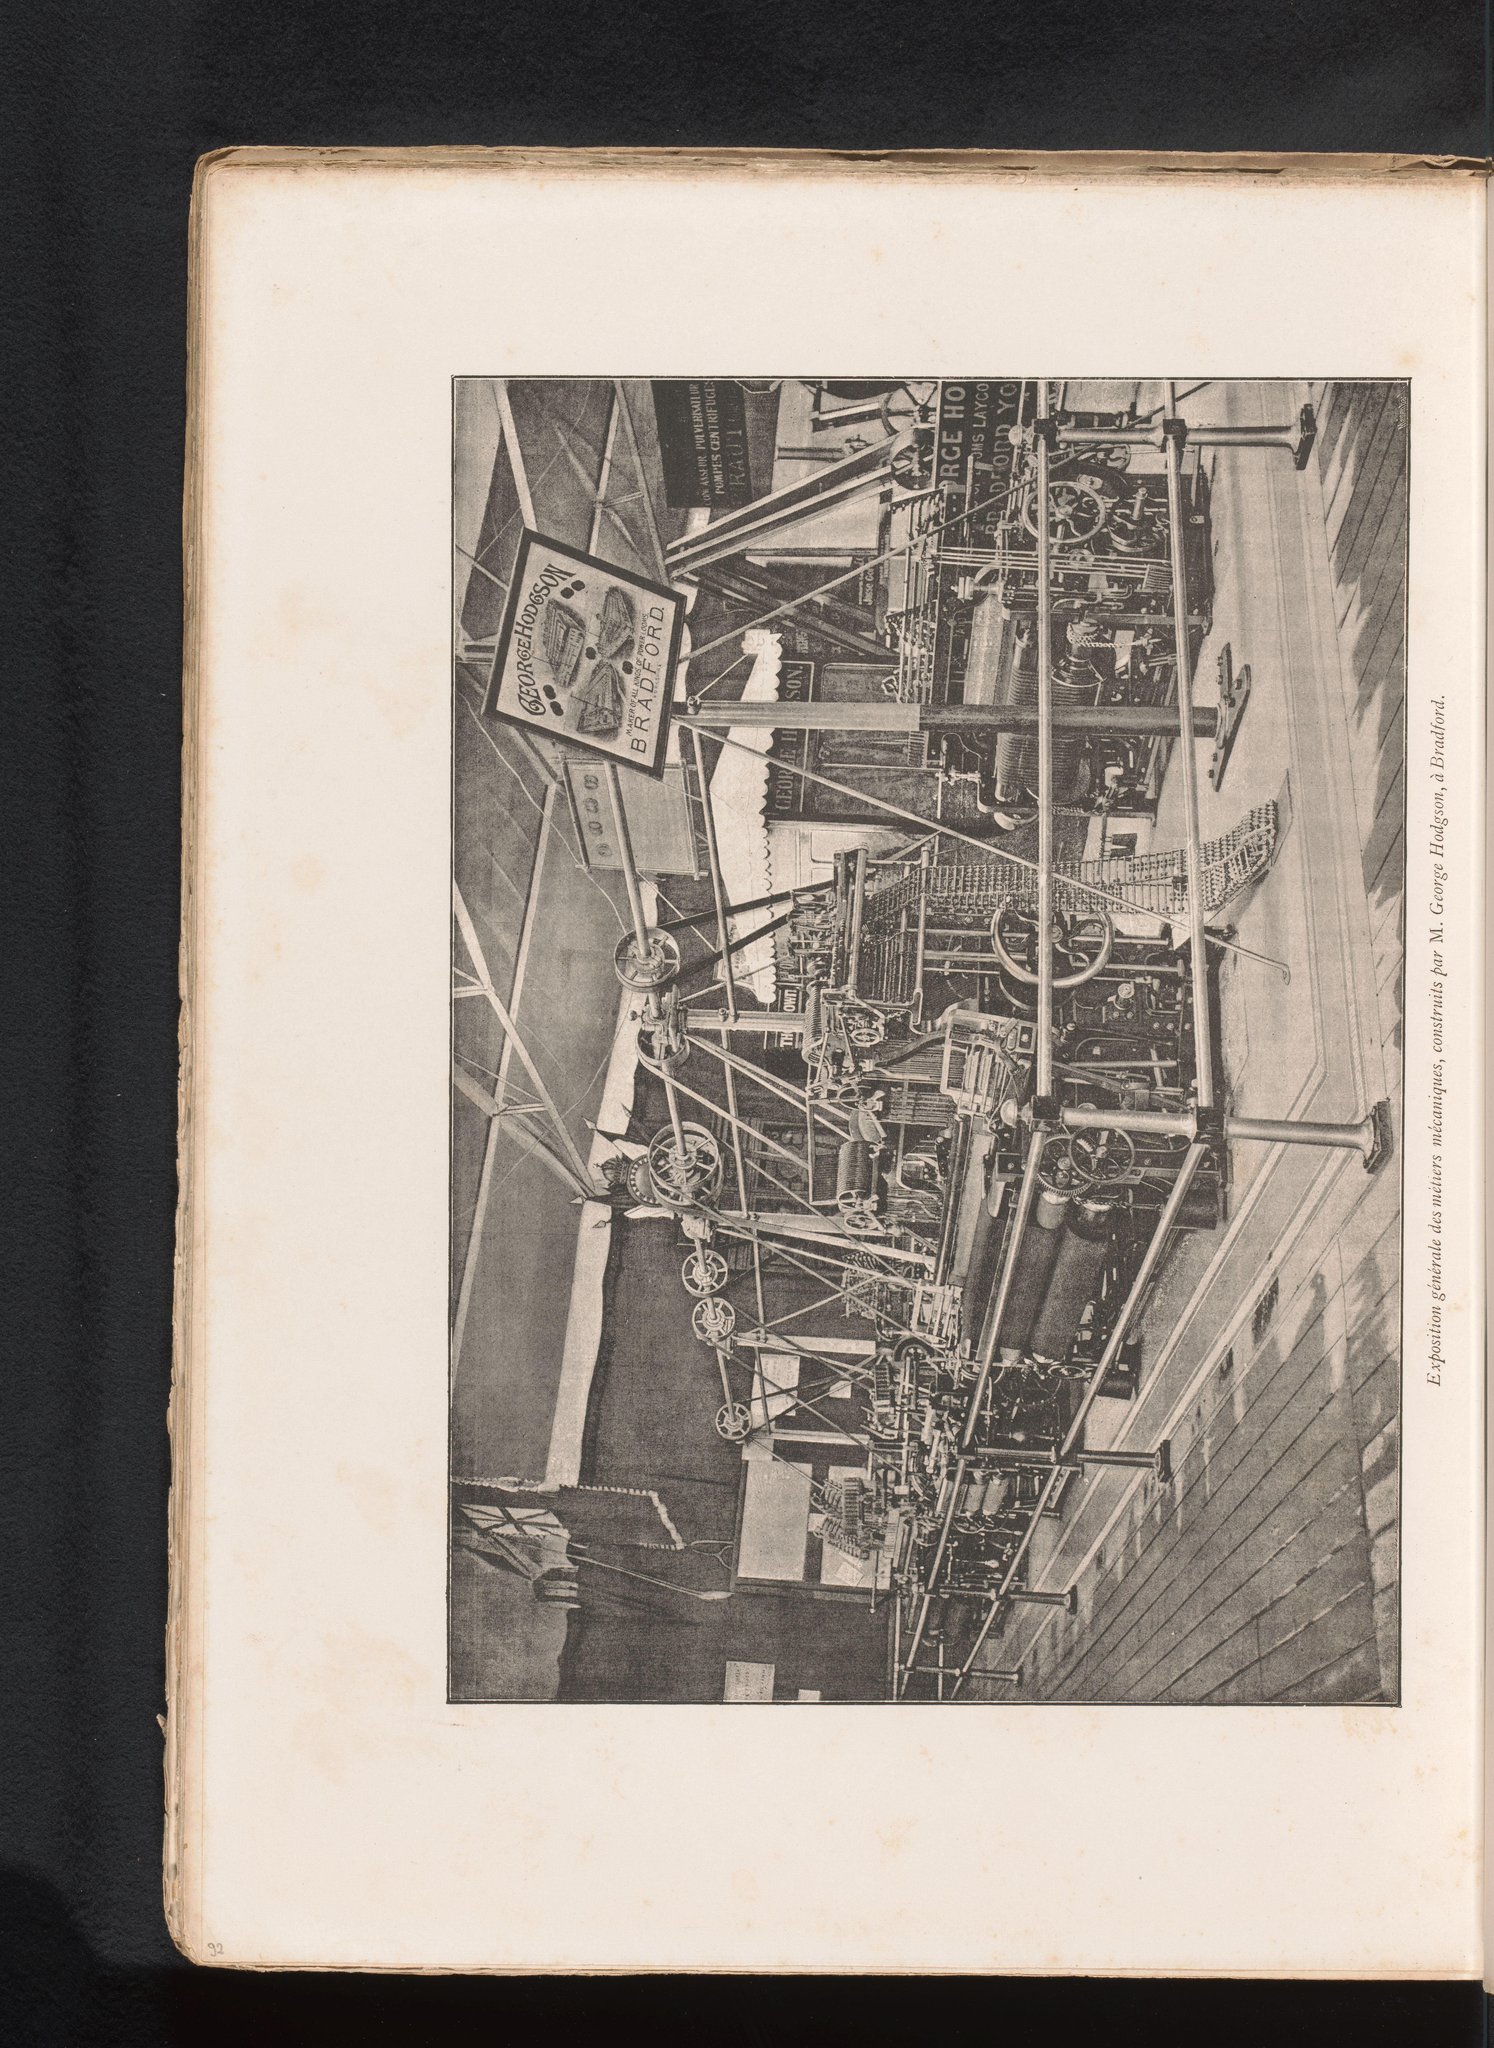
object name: photomechanical print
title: Exposition générale des métiers mécaniques, construits par M. George Hodgson, à Bradford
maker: Anonymous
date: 1880-1885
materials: paper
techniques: autotype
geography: antwerp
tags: world fair, world exhibition, antwerp